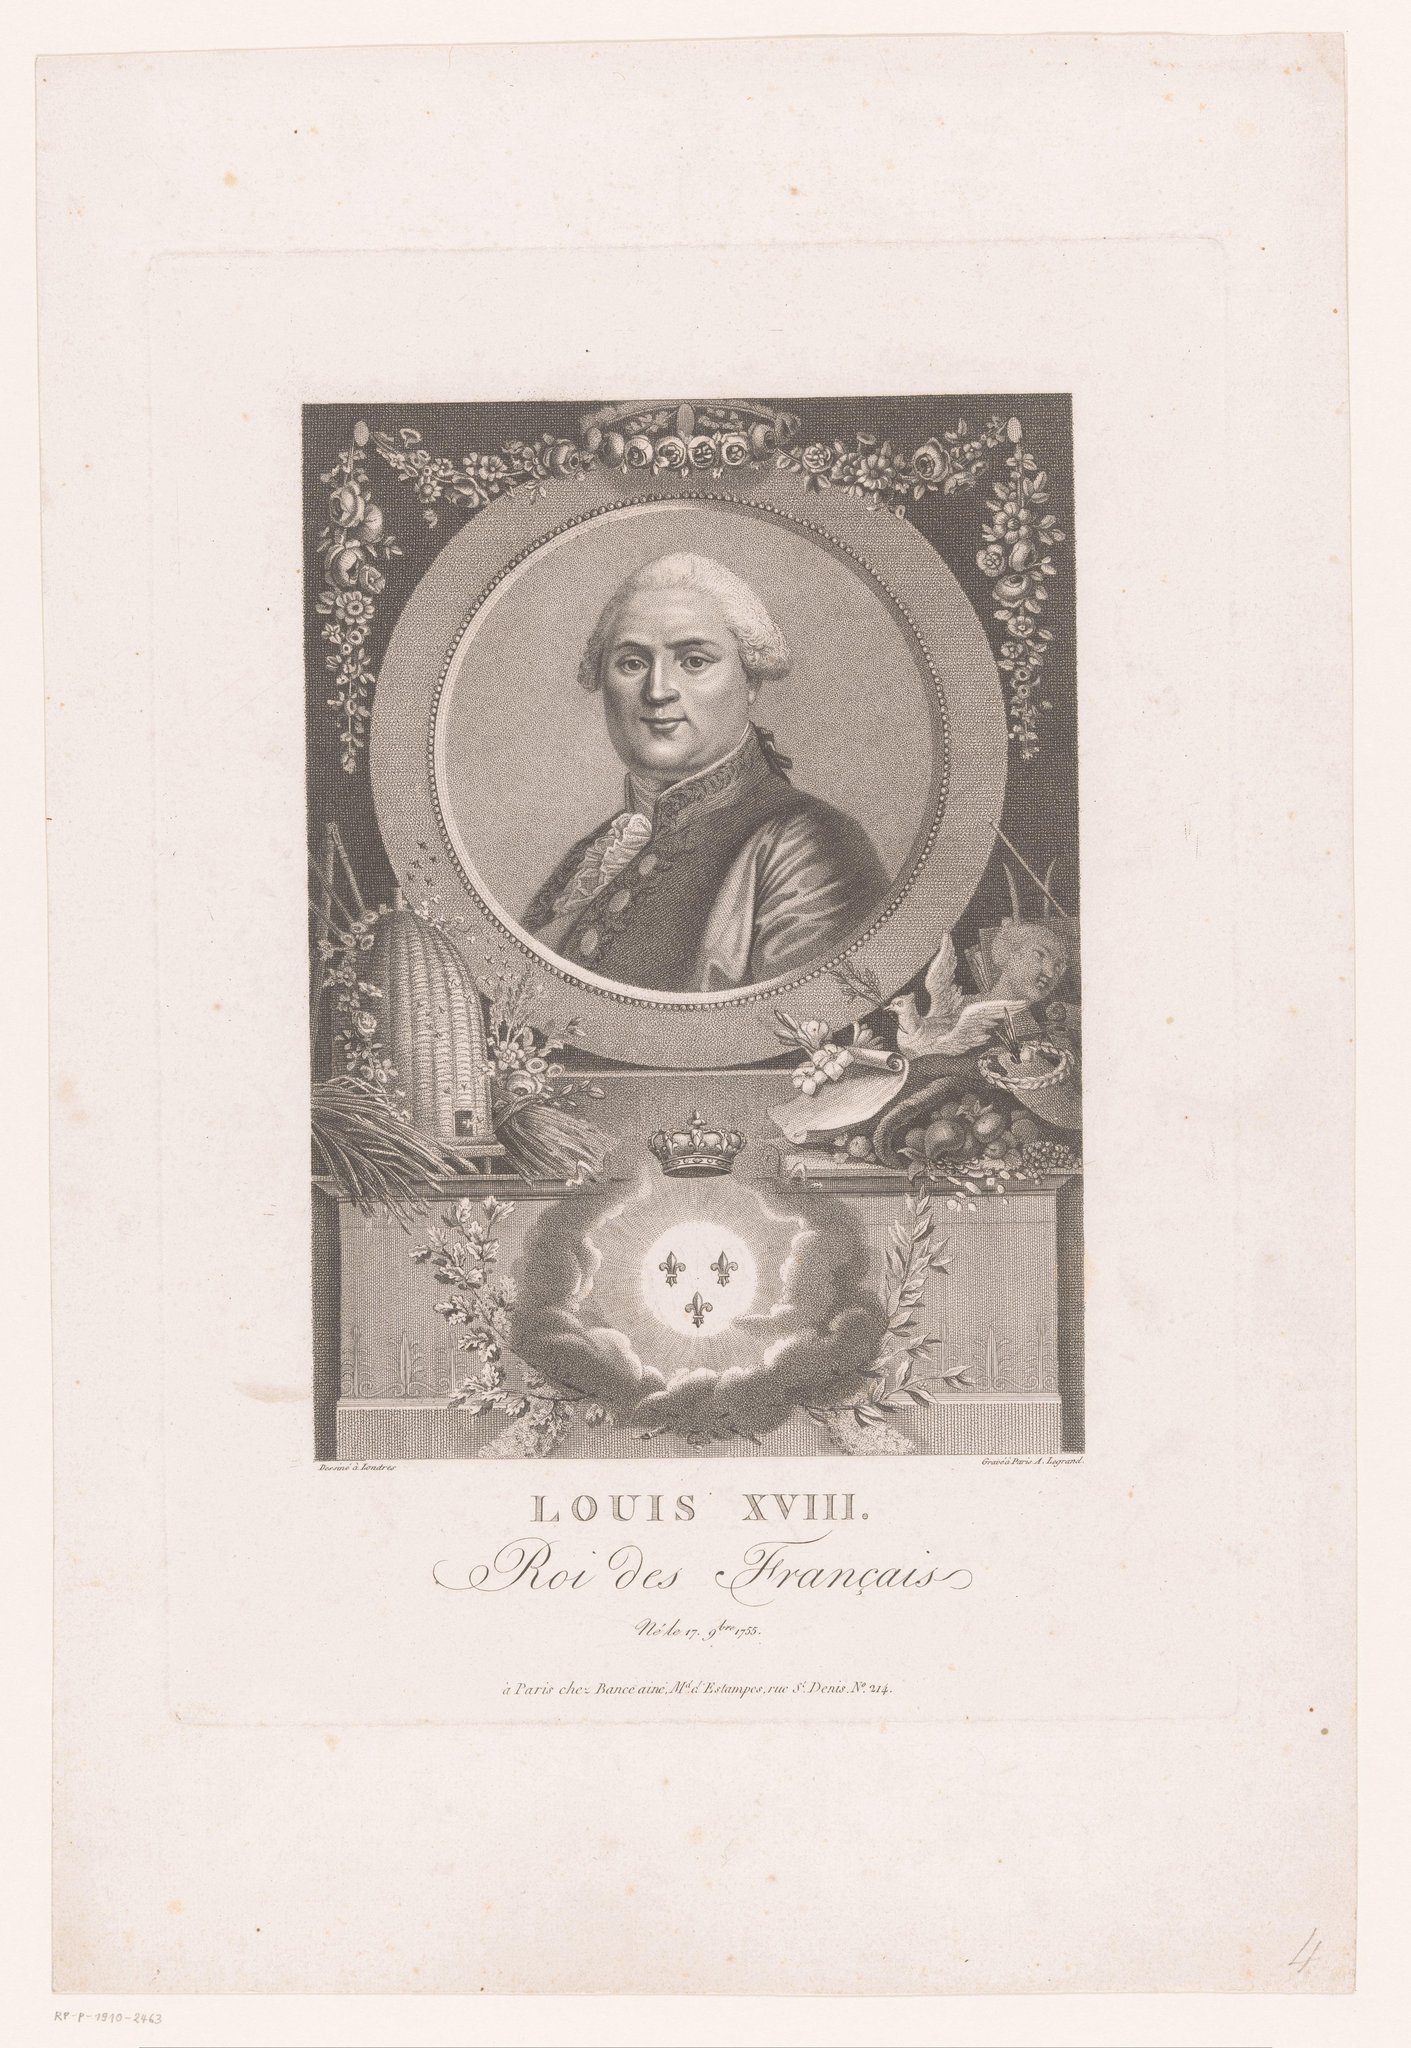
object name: print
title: Louis XVIII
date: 1815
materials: paper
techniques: etching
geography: london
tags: paris, lodewijk xviii (koning van frankrijk), historical persons, ruler, sovereign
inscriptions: collector's mark: Lugt 2228